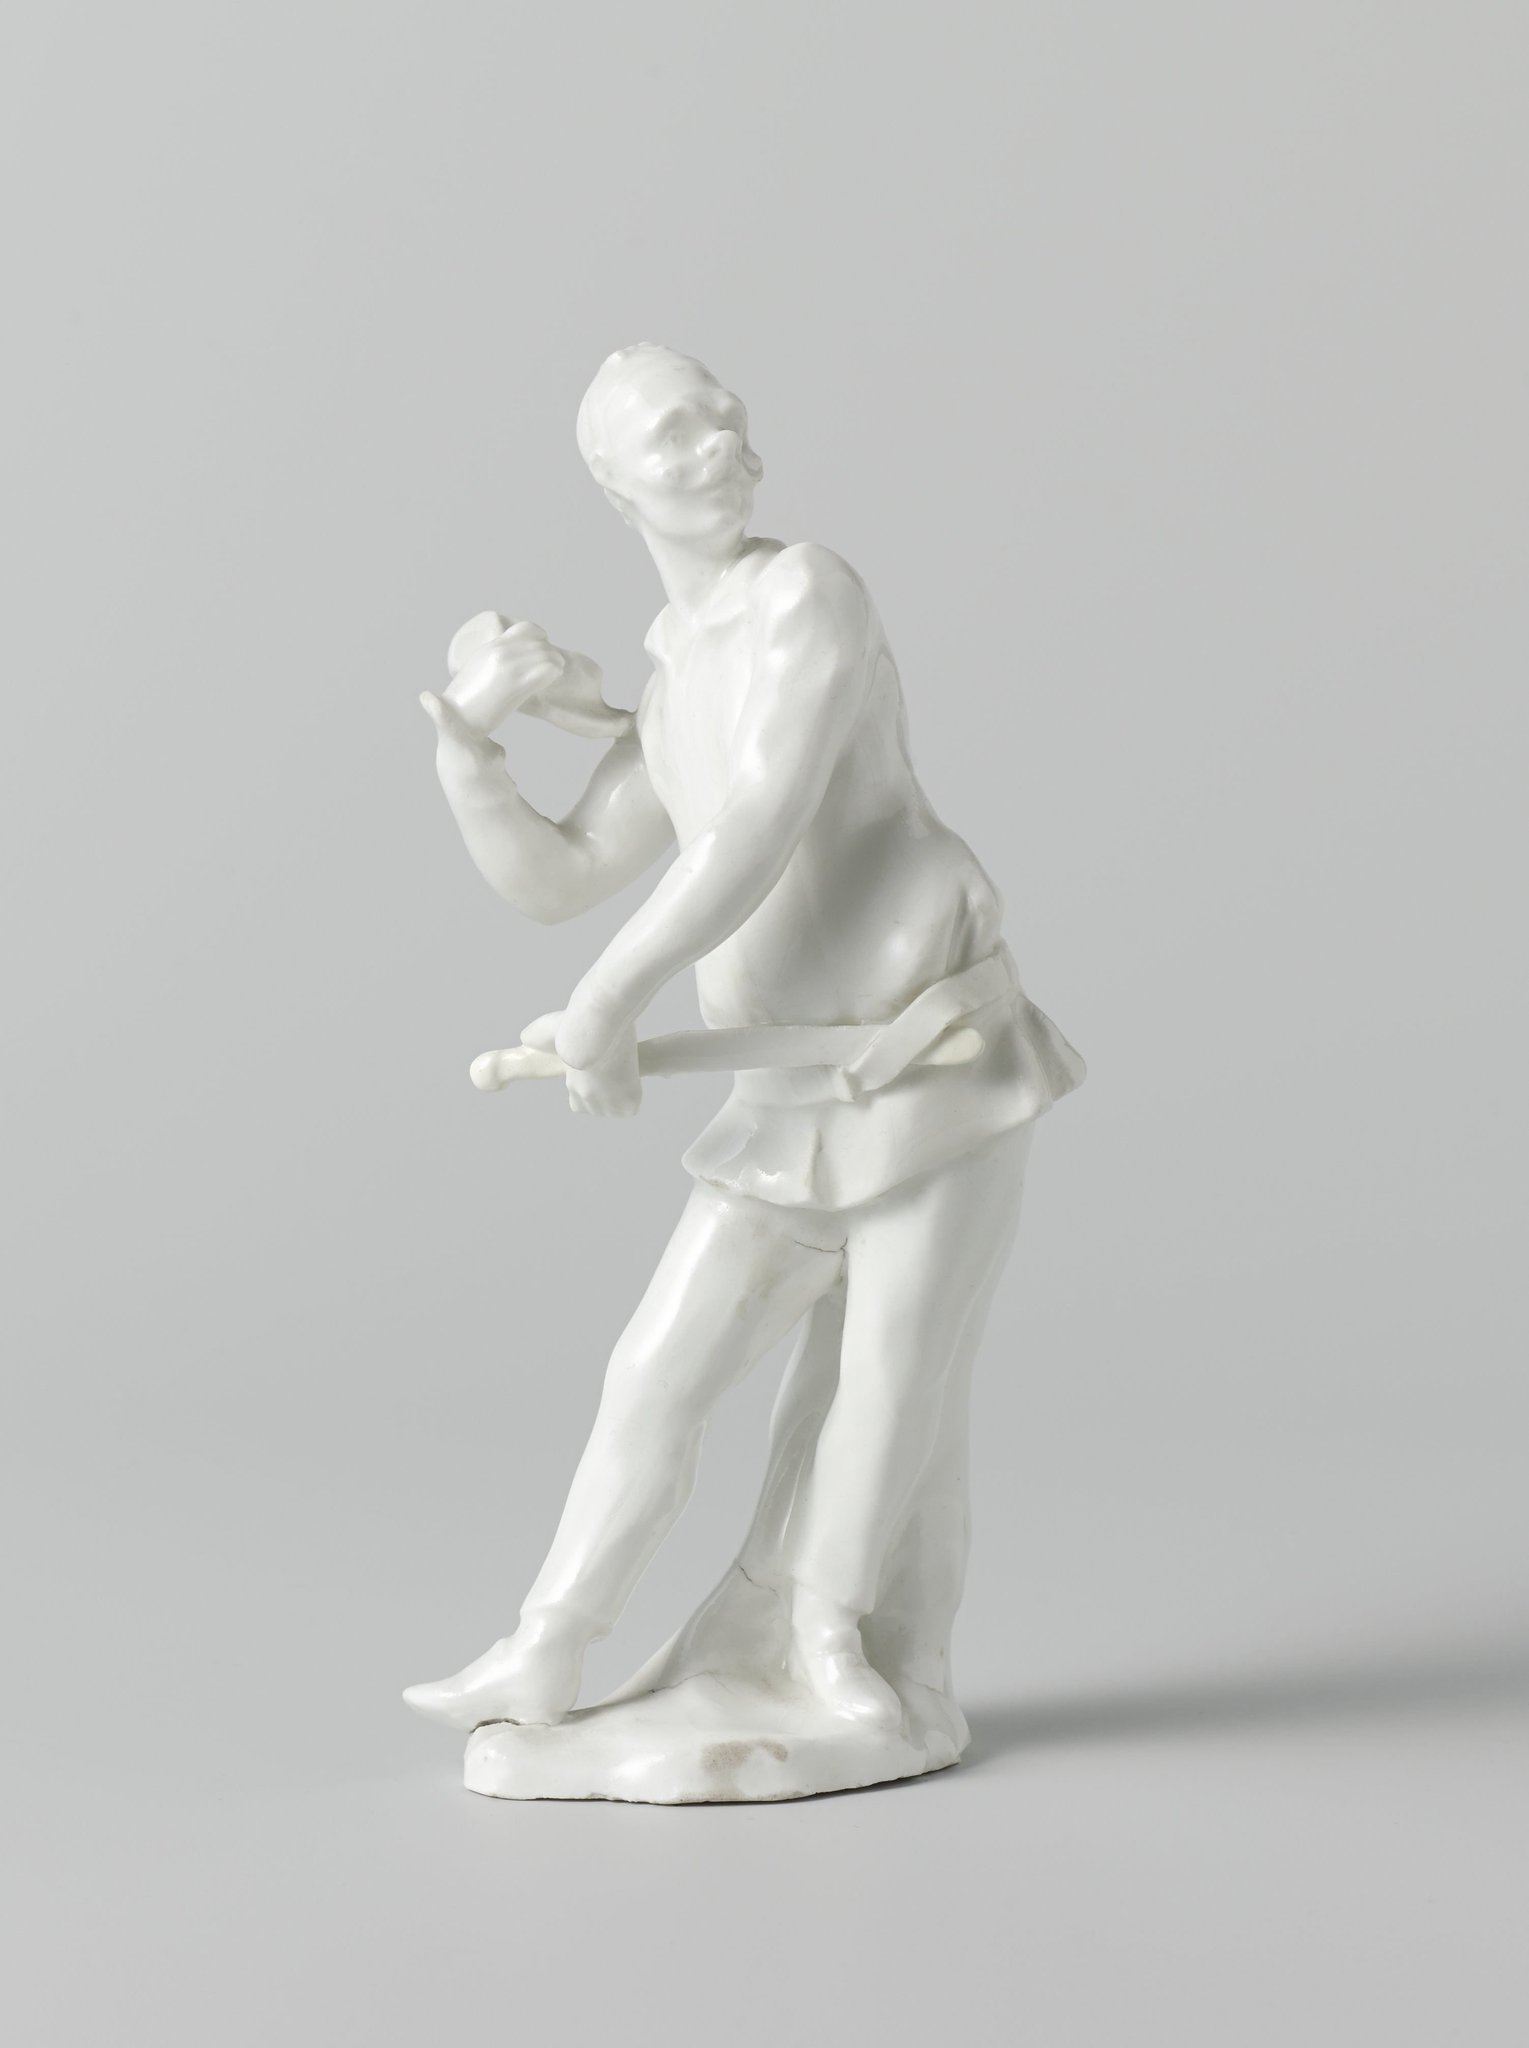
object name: figure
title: Figure of a harlequin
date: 1744-1749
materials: glaze, porcelain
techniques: firing, forming, vitrification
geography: vienna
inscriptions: mark: ‘schild/ V/ N’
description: Harlequin, from the Commedia dell' Arte. Porcelain. Vienna, c. 1744 - 1749.